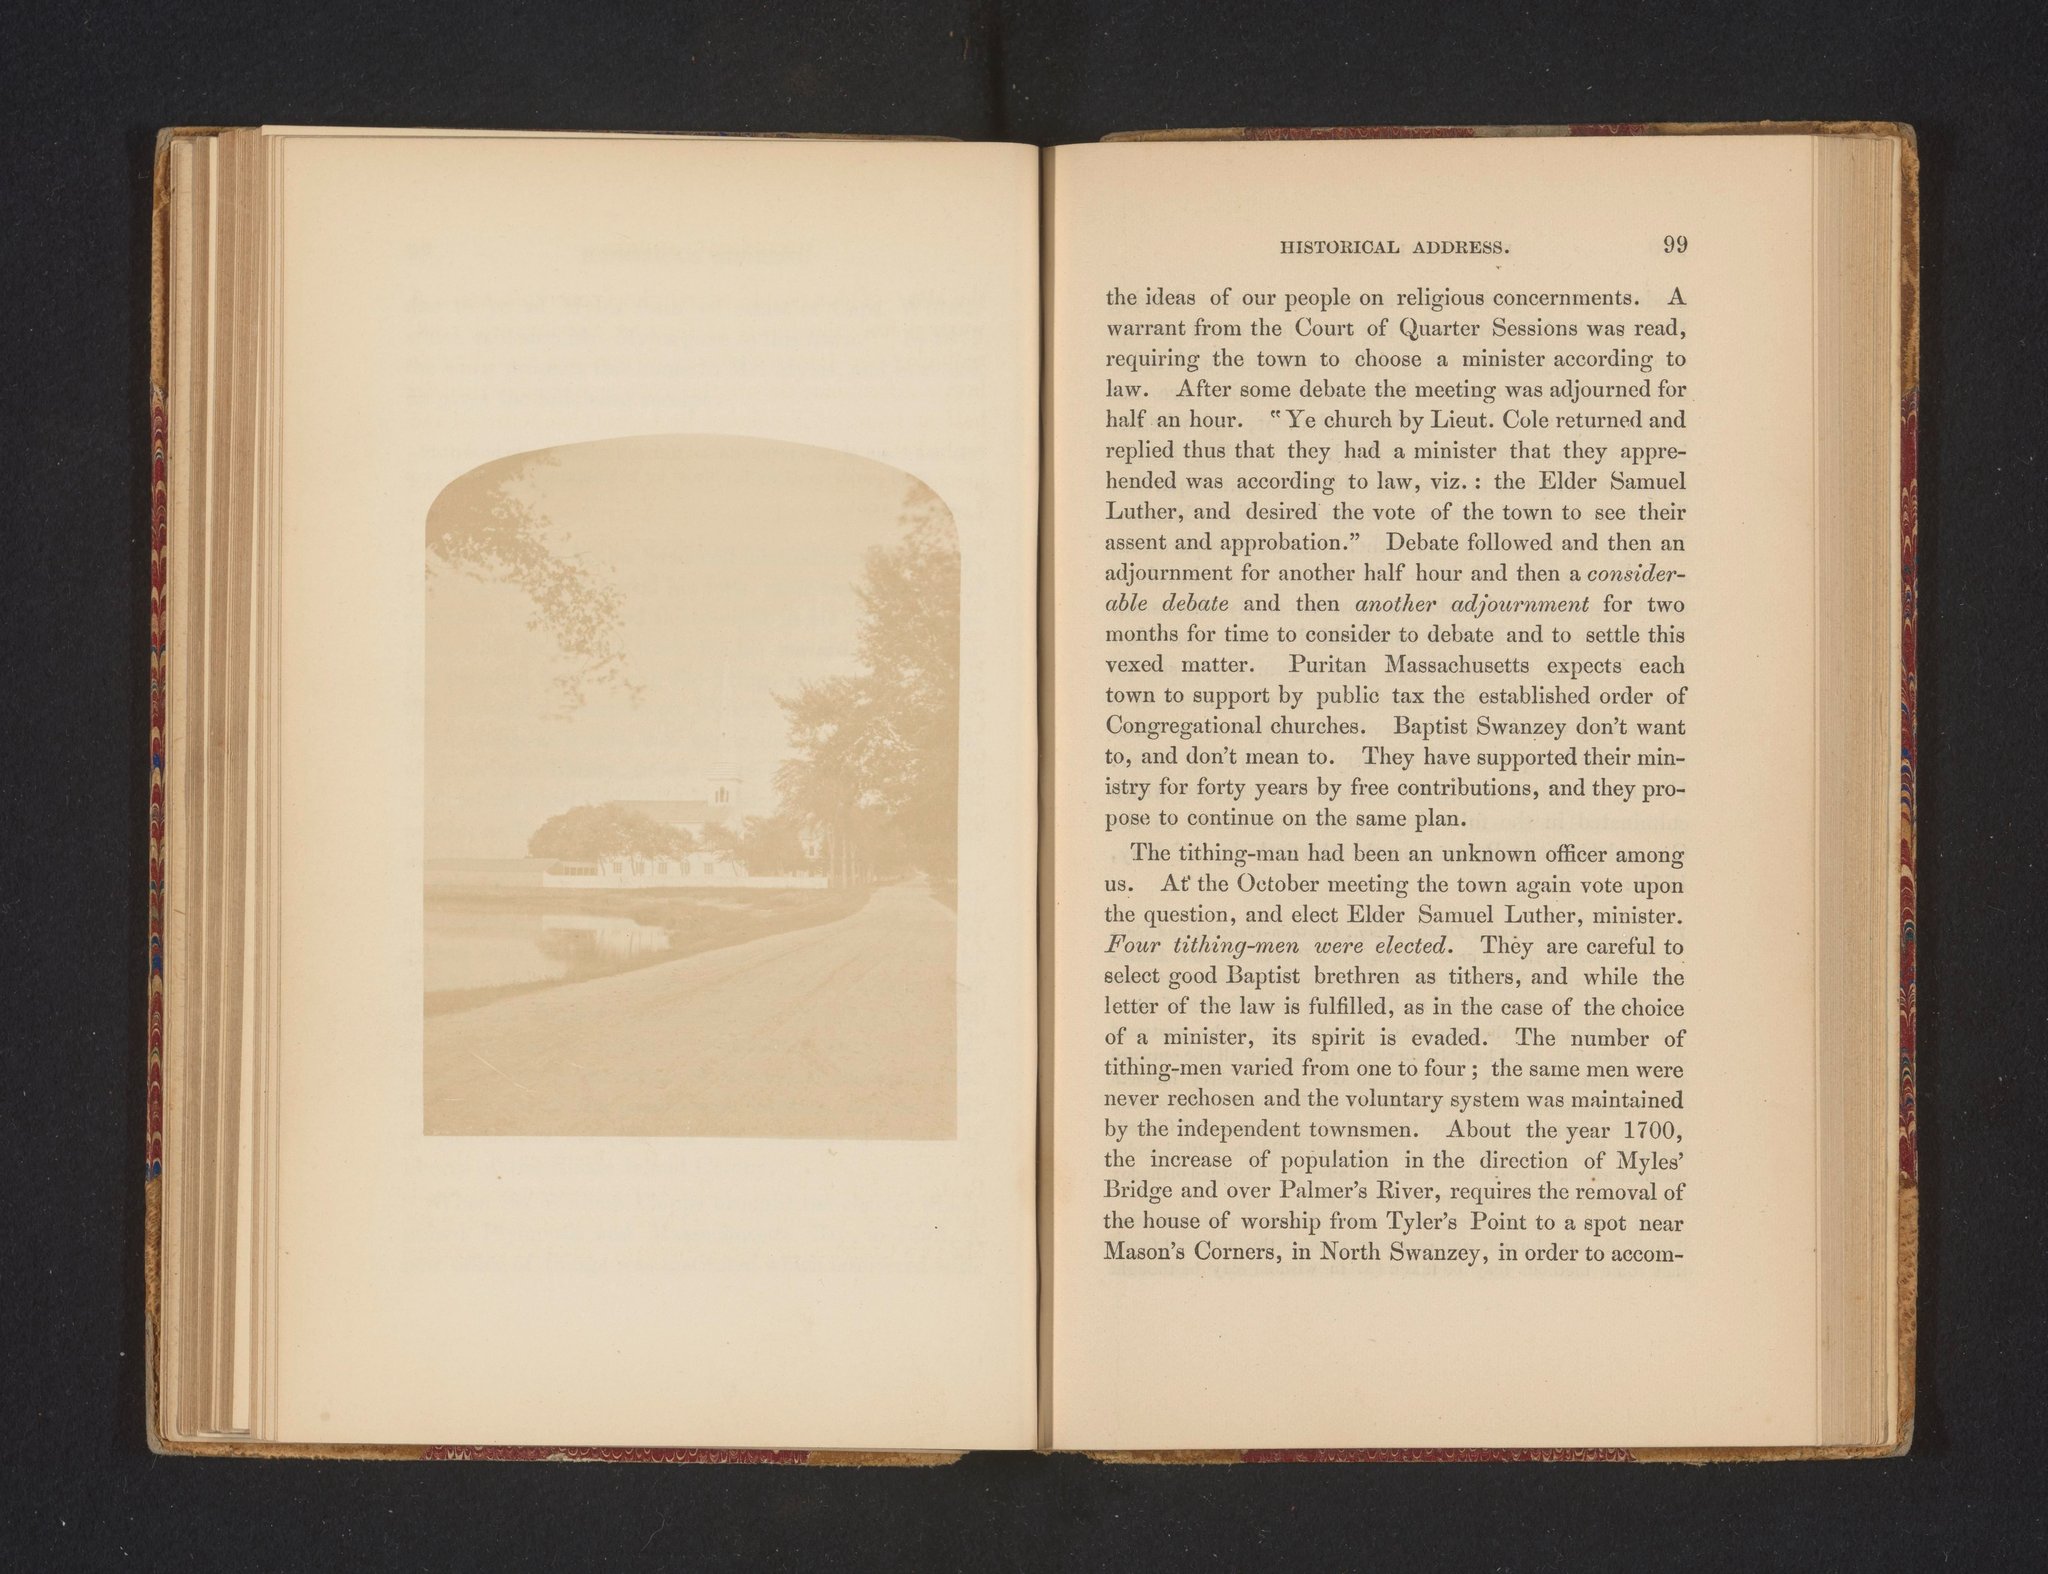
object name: photograph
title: Gezicht op een kerk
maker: Anonymous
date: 1865-1870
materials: photographic support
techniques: salted paper print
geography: barrington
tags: landscapes, church (exterior)